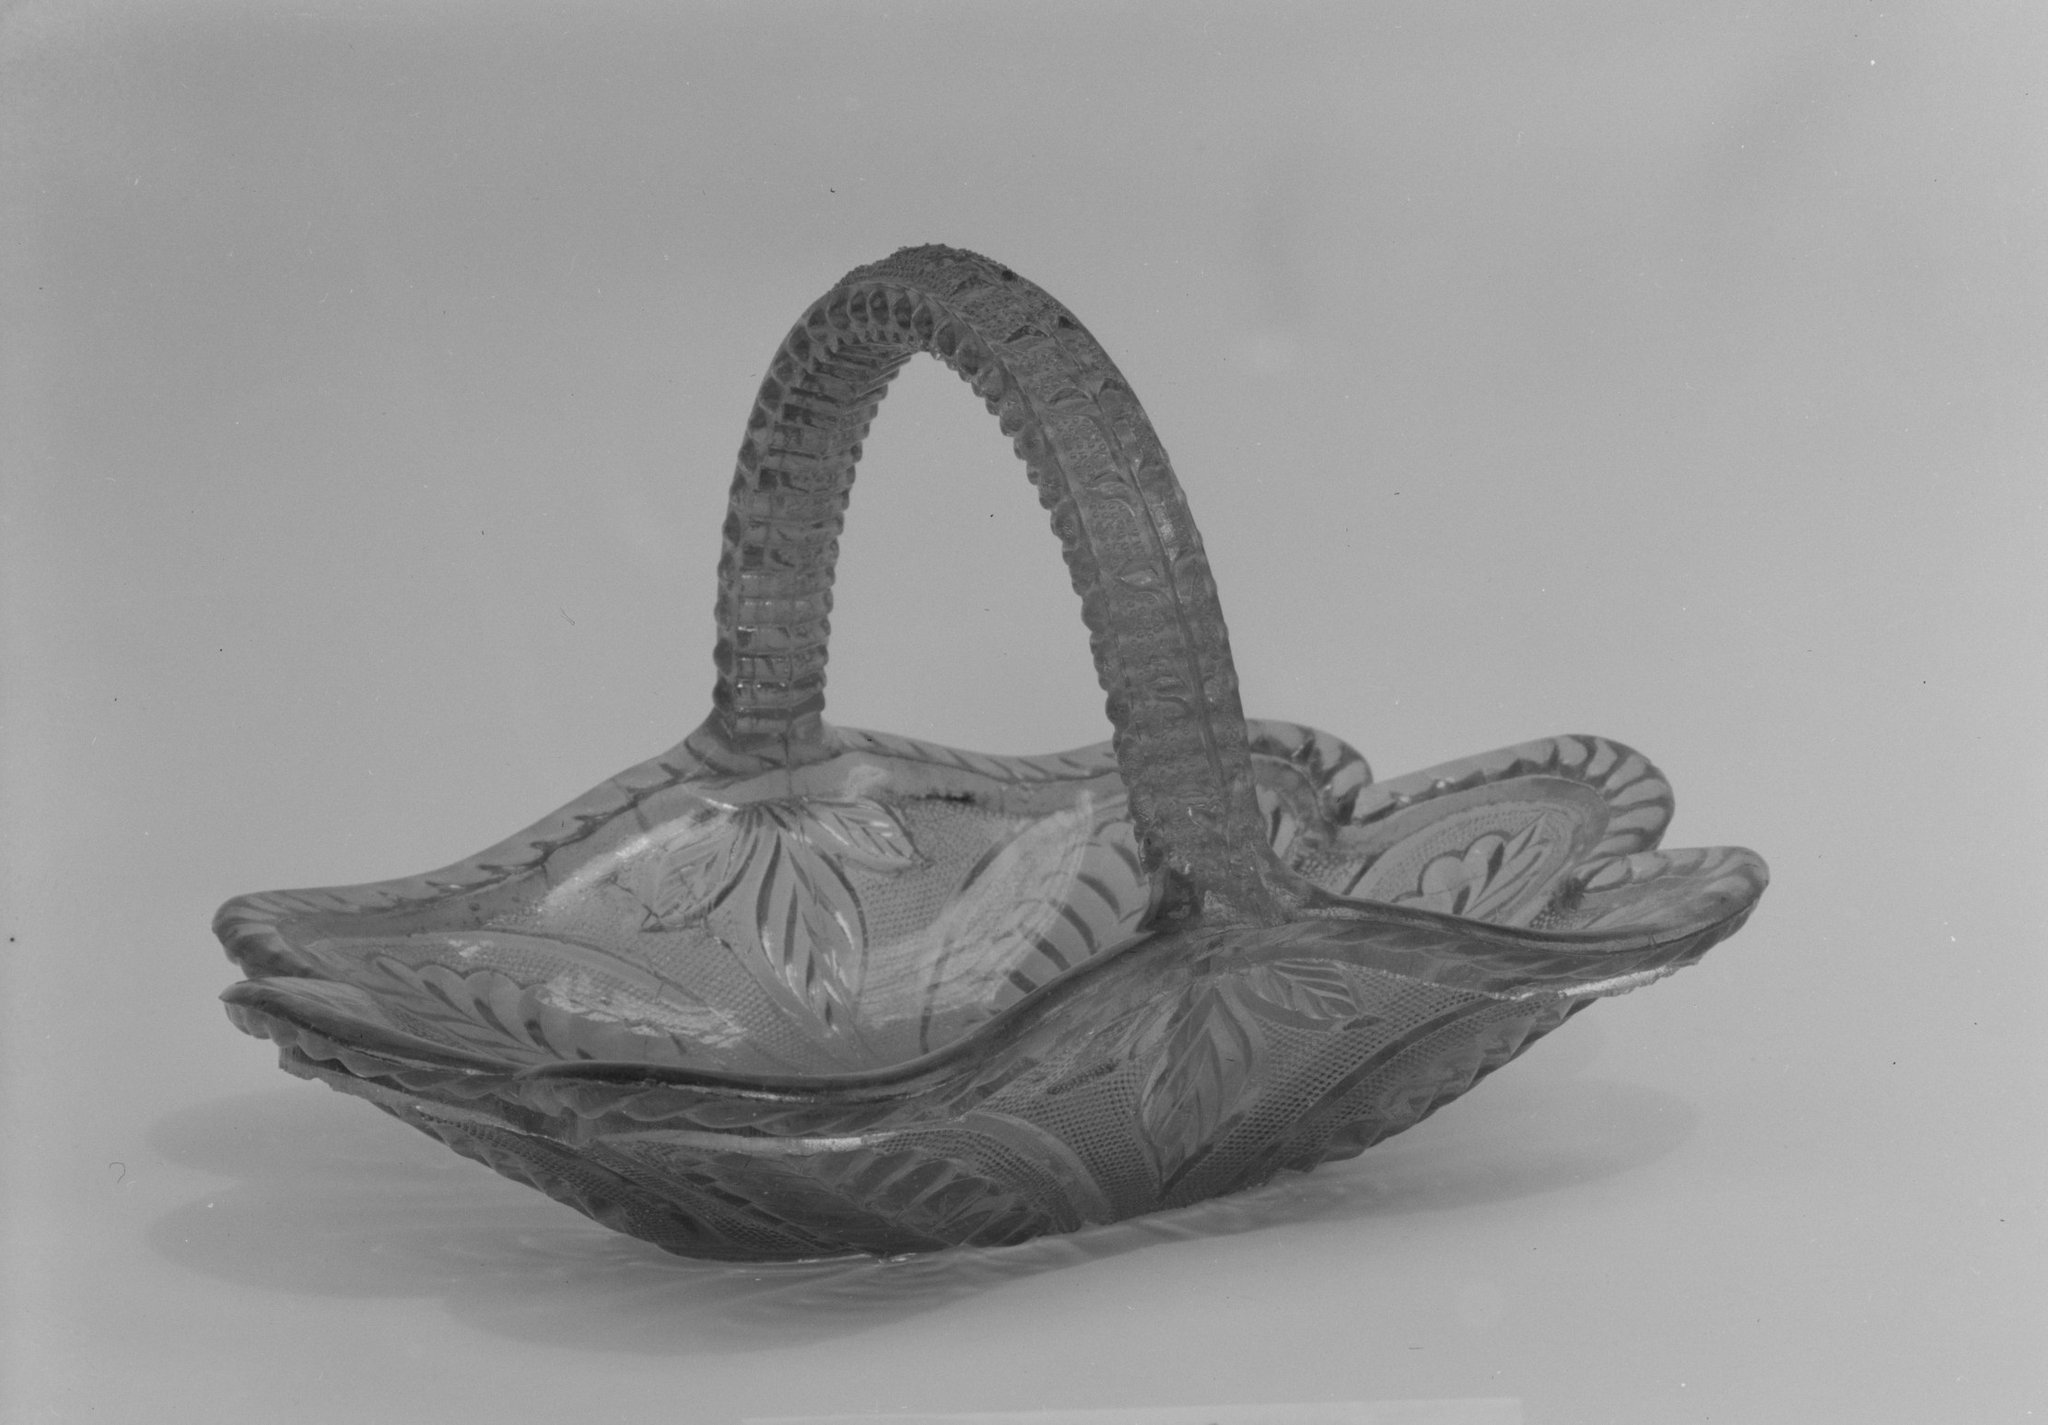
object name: basket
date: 1830-1900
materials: glass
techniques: pressed